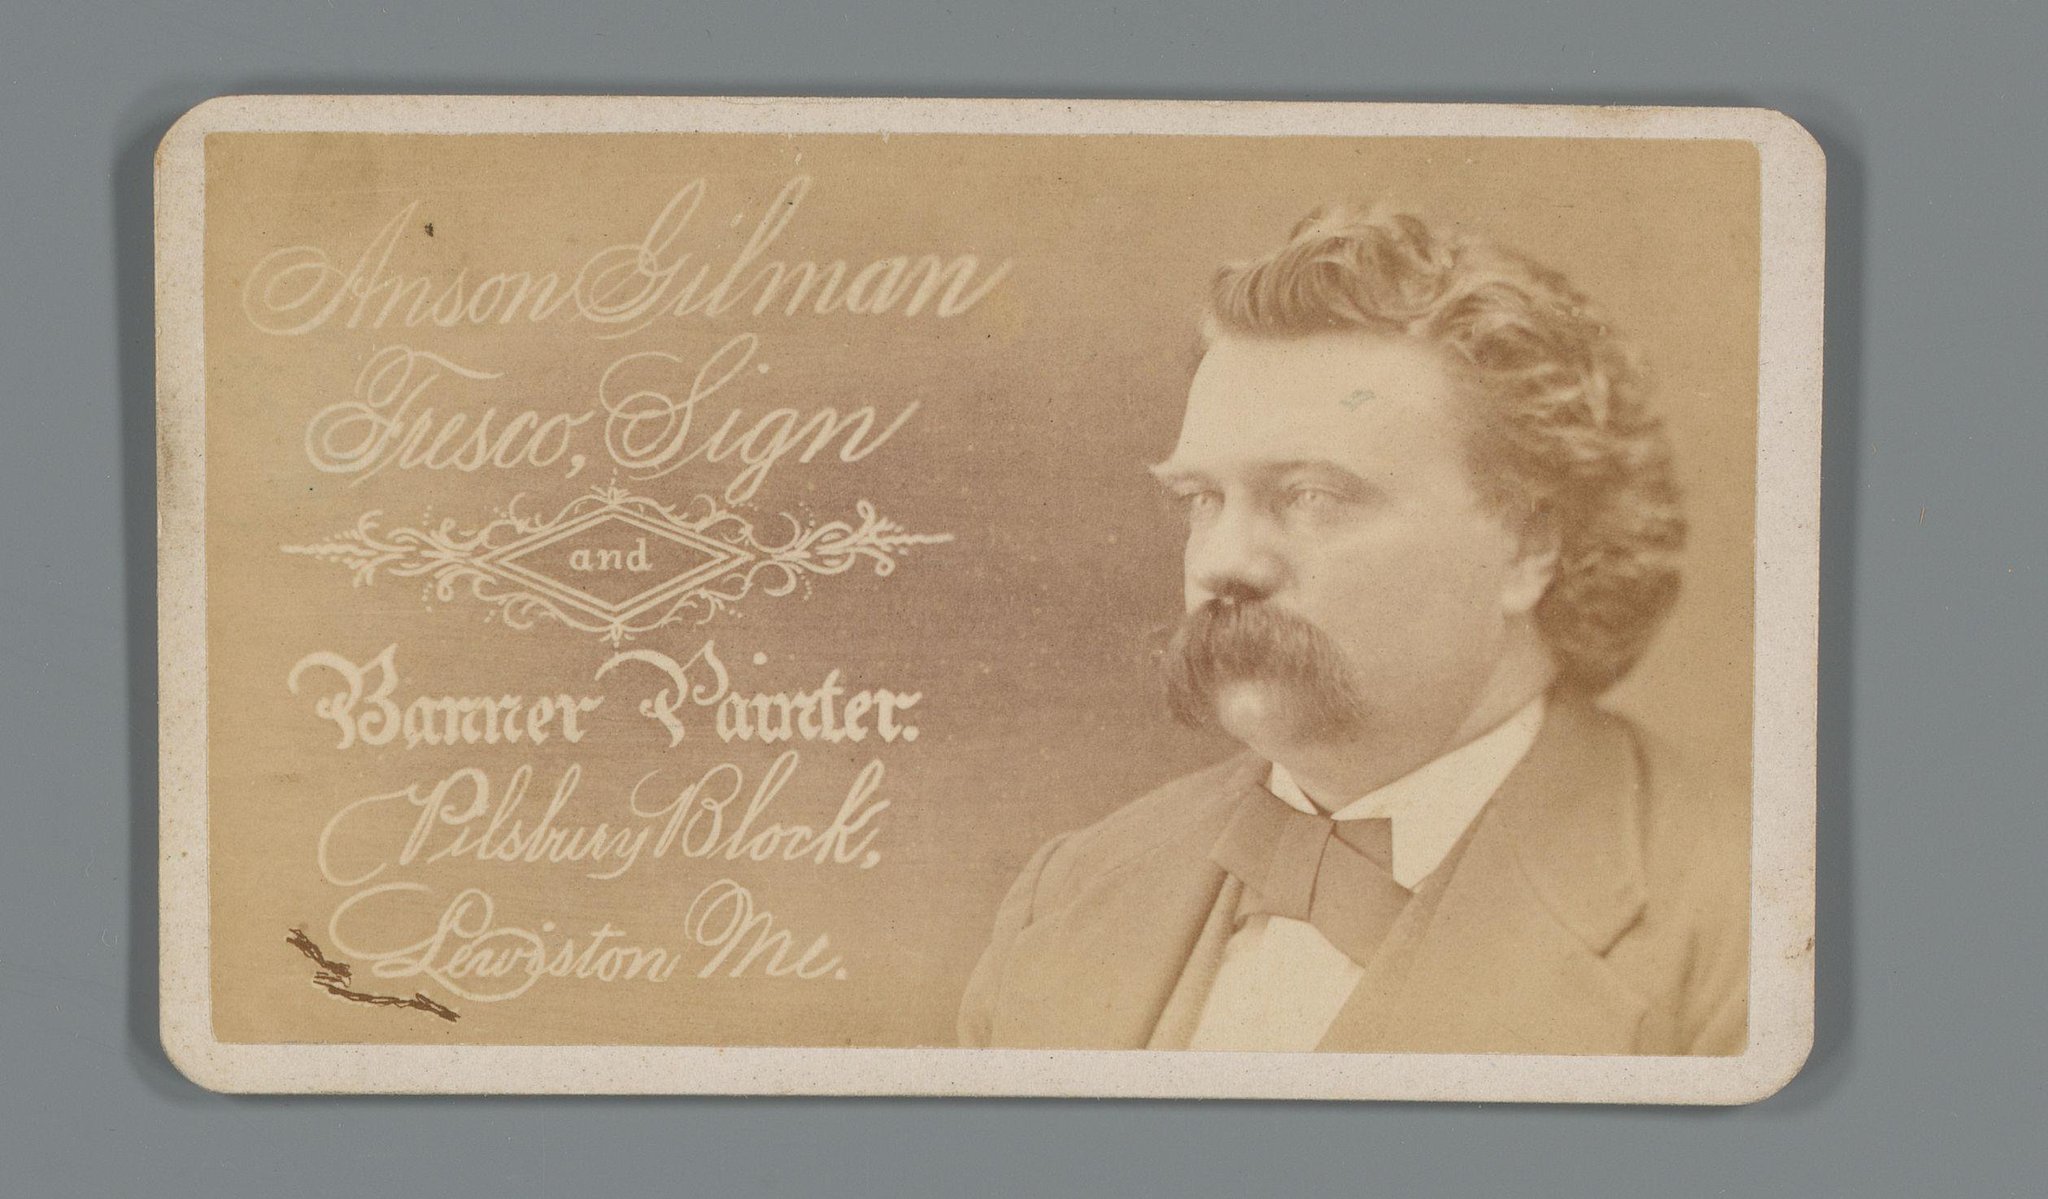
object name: photograph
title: Portret van Anson Gilman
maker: a.g. cates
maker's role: fotograaf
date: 1850-1915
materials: cardboard, photographic support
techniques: albumen print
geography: lewiston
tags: painter, advertising, mural painter, historical persons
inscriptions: inscription: ‘A.G. CATES/ PORTRAIT & LANDSCAPE/ PHOTOGRAPHER/ PILSBURY BLOCK./ LEWISTON.’